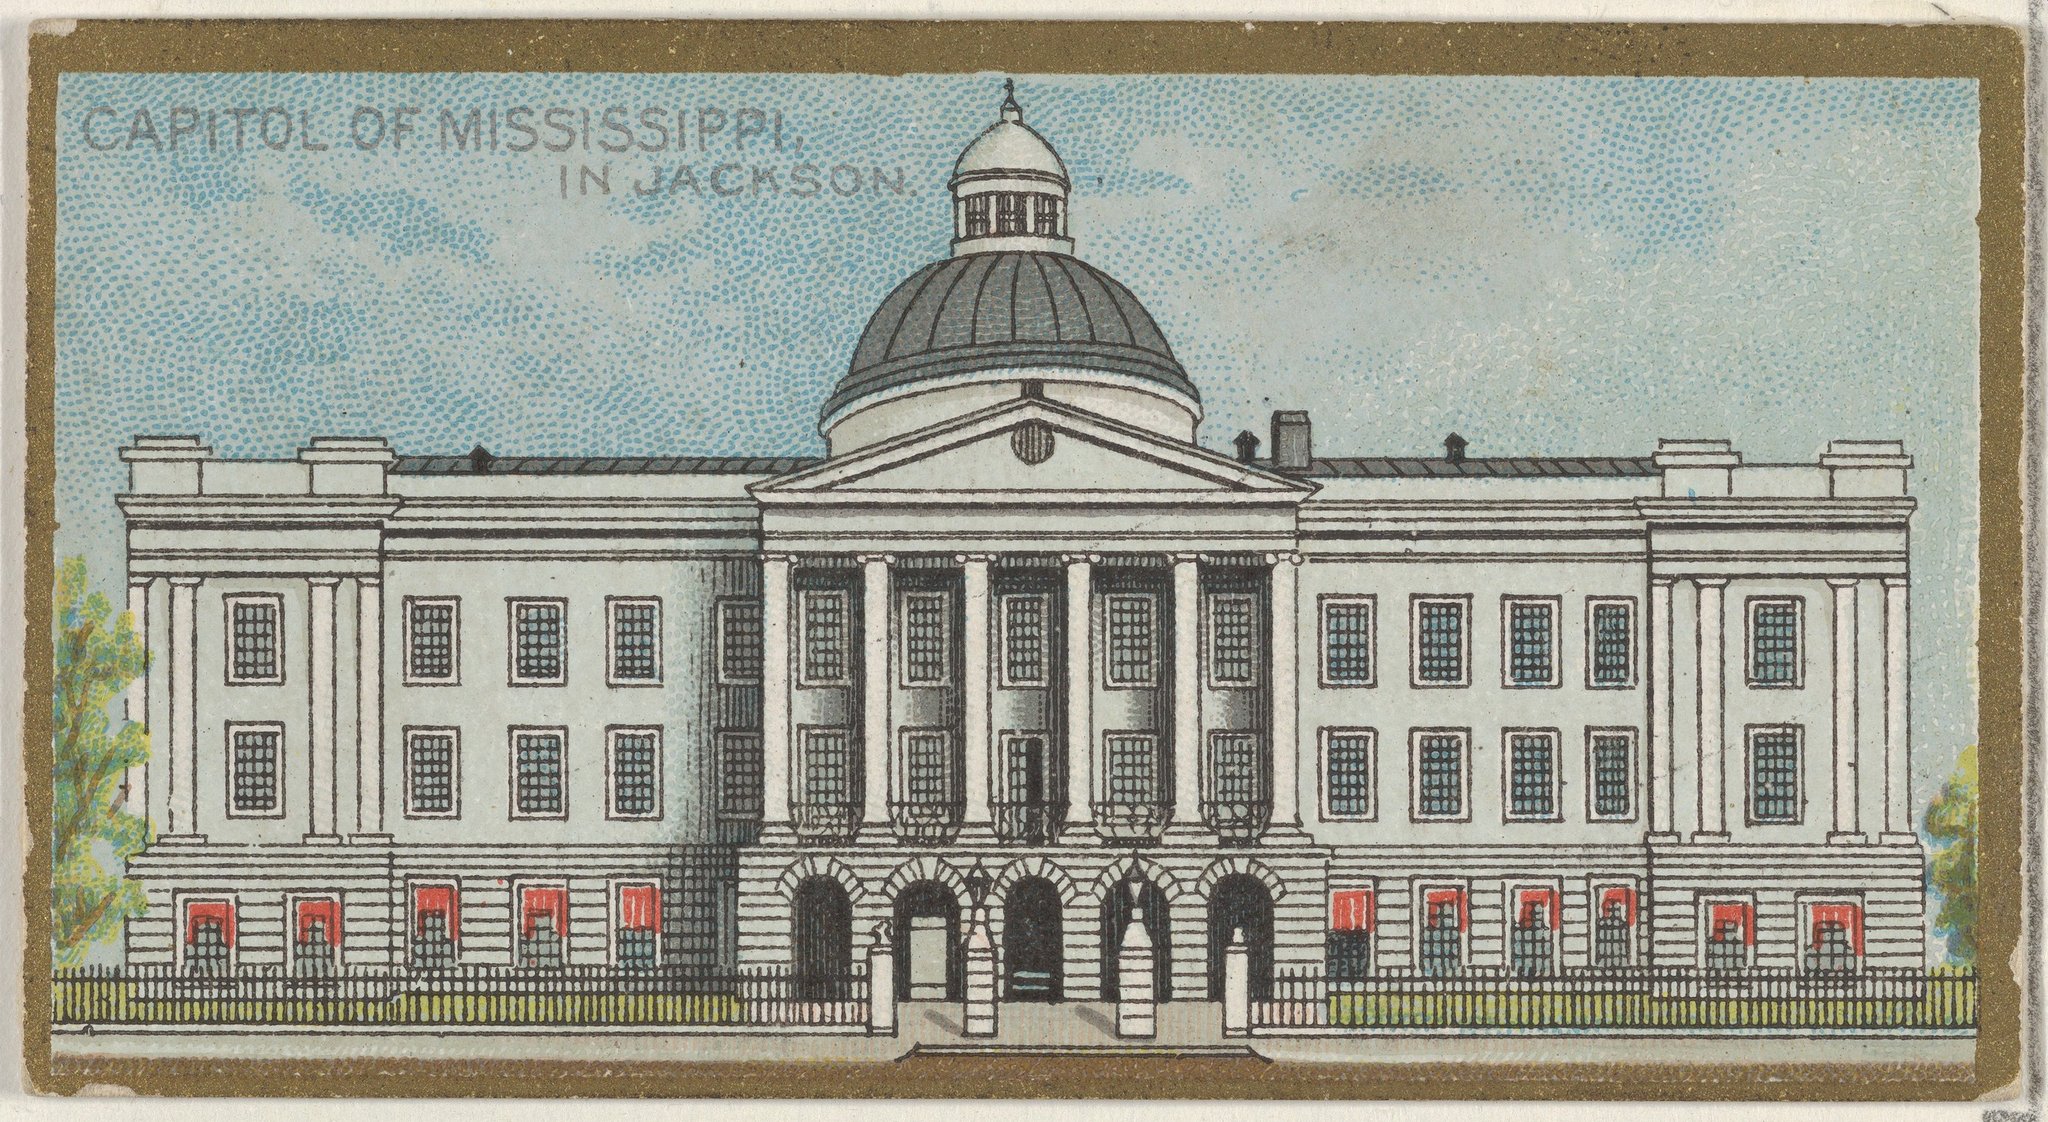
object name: print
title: Capitol of Mississippi in Jackson, from the General Government and State Capitol Buildings series (N14) for Allen & Ginter Cigarettes Brands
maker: allen & ginter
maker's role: publisher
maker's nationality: american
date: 1889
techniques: color lithograph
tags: buildings